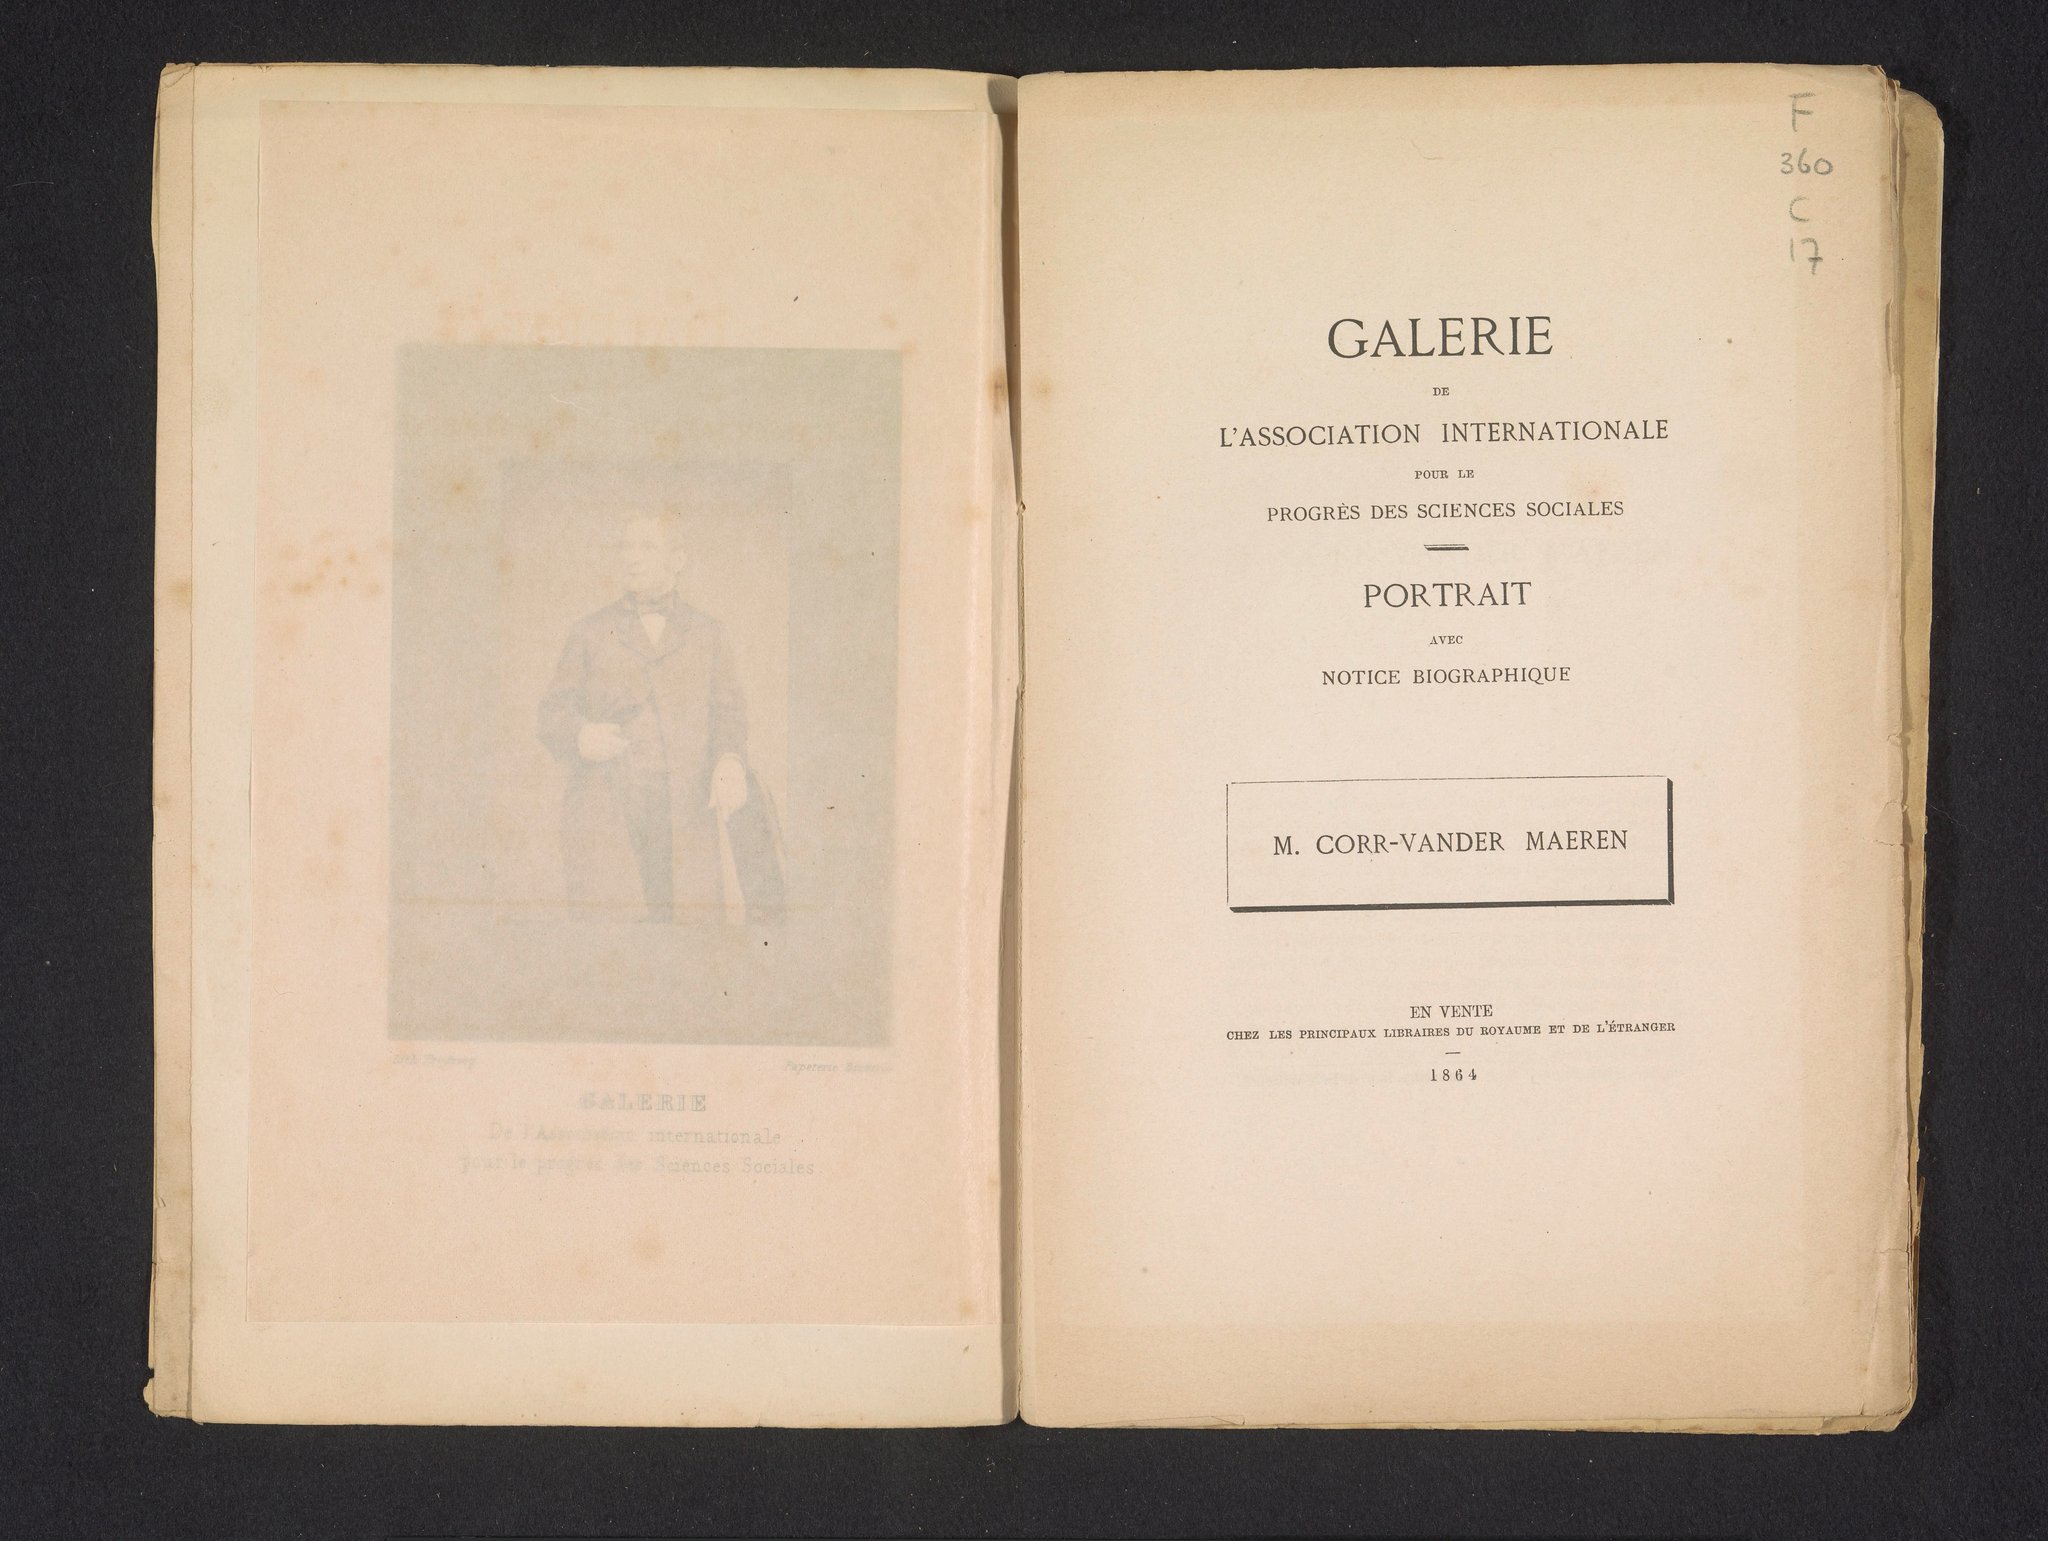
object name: book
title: Galerie de l'Association internationale pour de progrès des sciences sociales : portrait avec notice biographique / [Edouard Sève]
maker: édouard sève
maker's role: schrijver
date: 1864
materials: paper, photographic support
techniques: albumen print, lithograph, printing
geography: brussels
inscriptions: annotation: ‘Brabant’, annotation: ‘[...]’